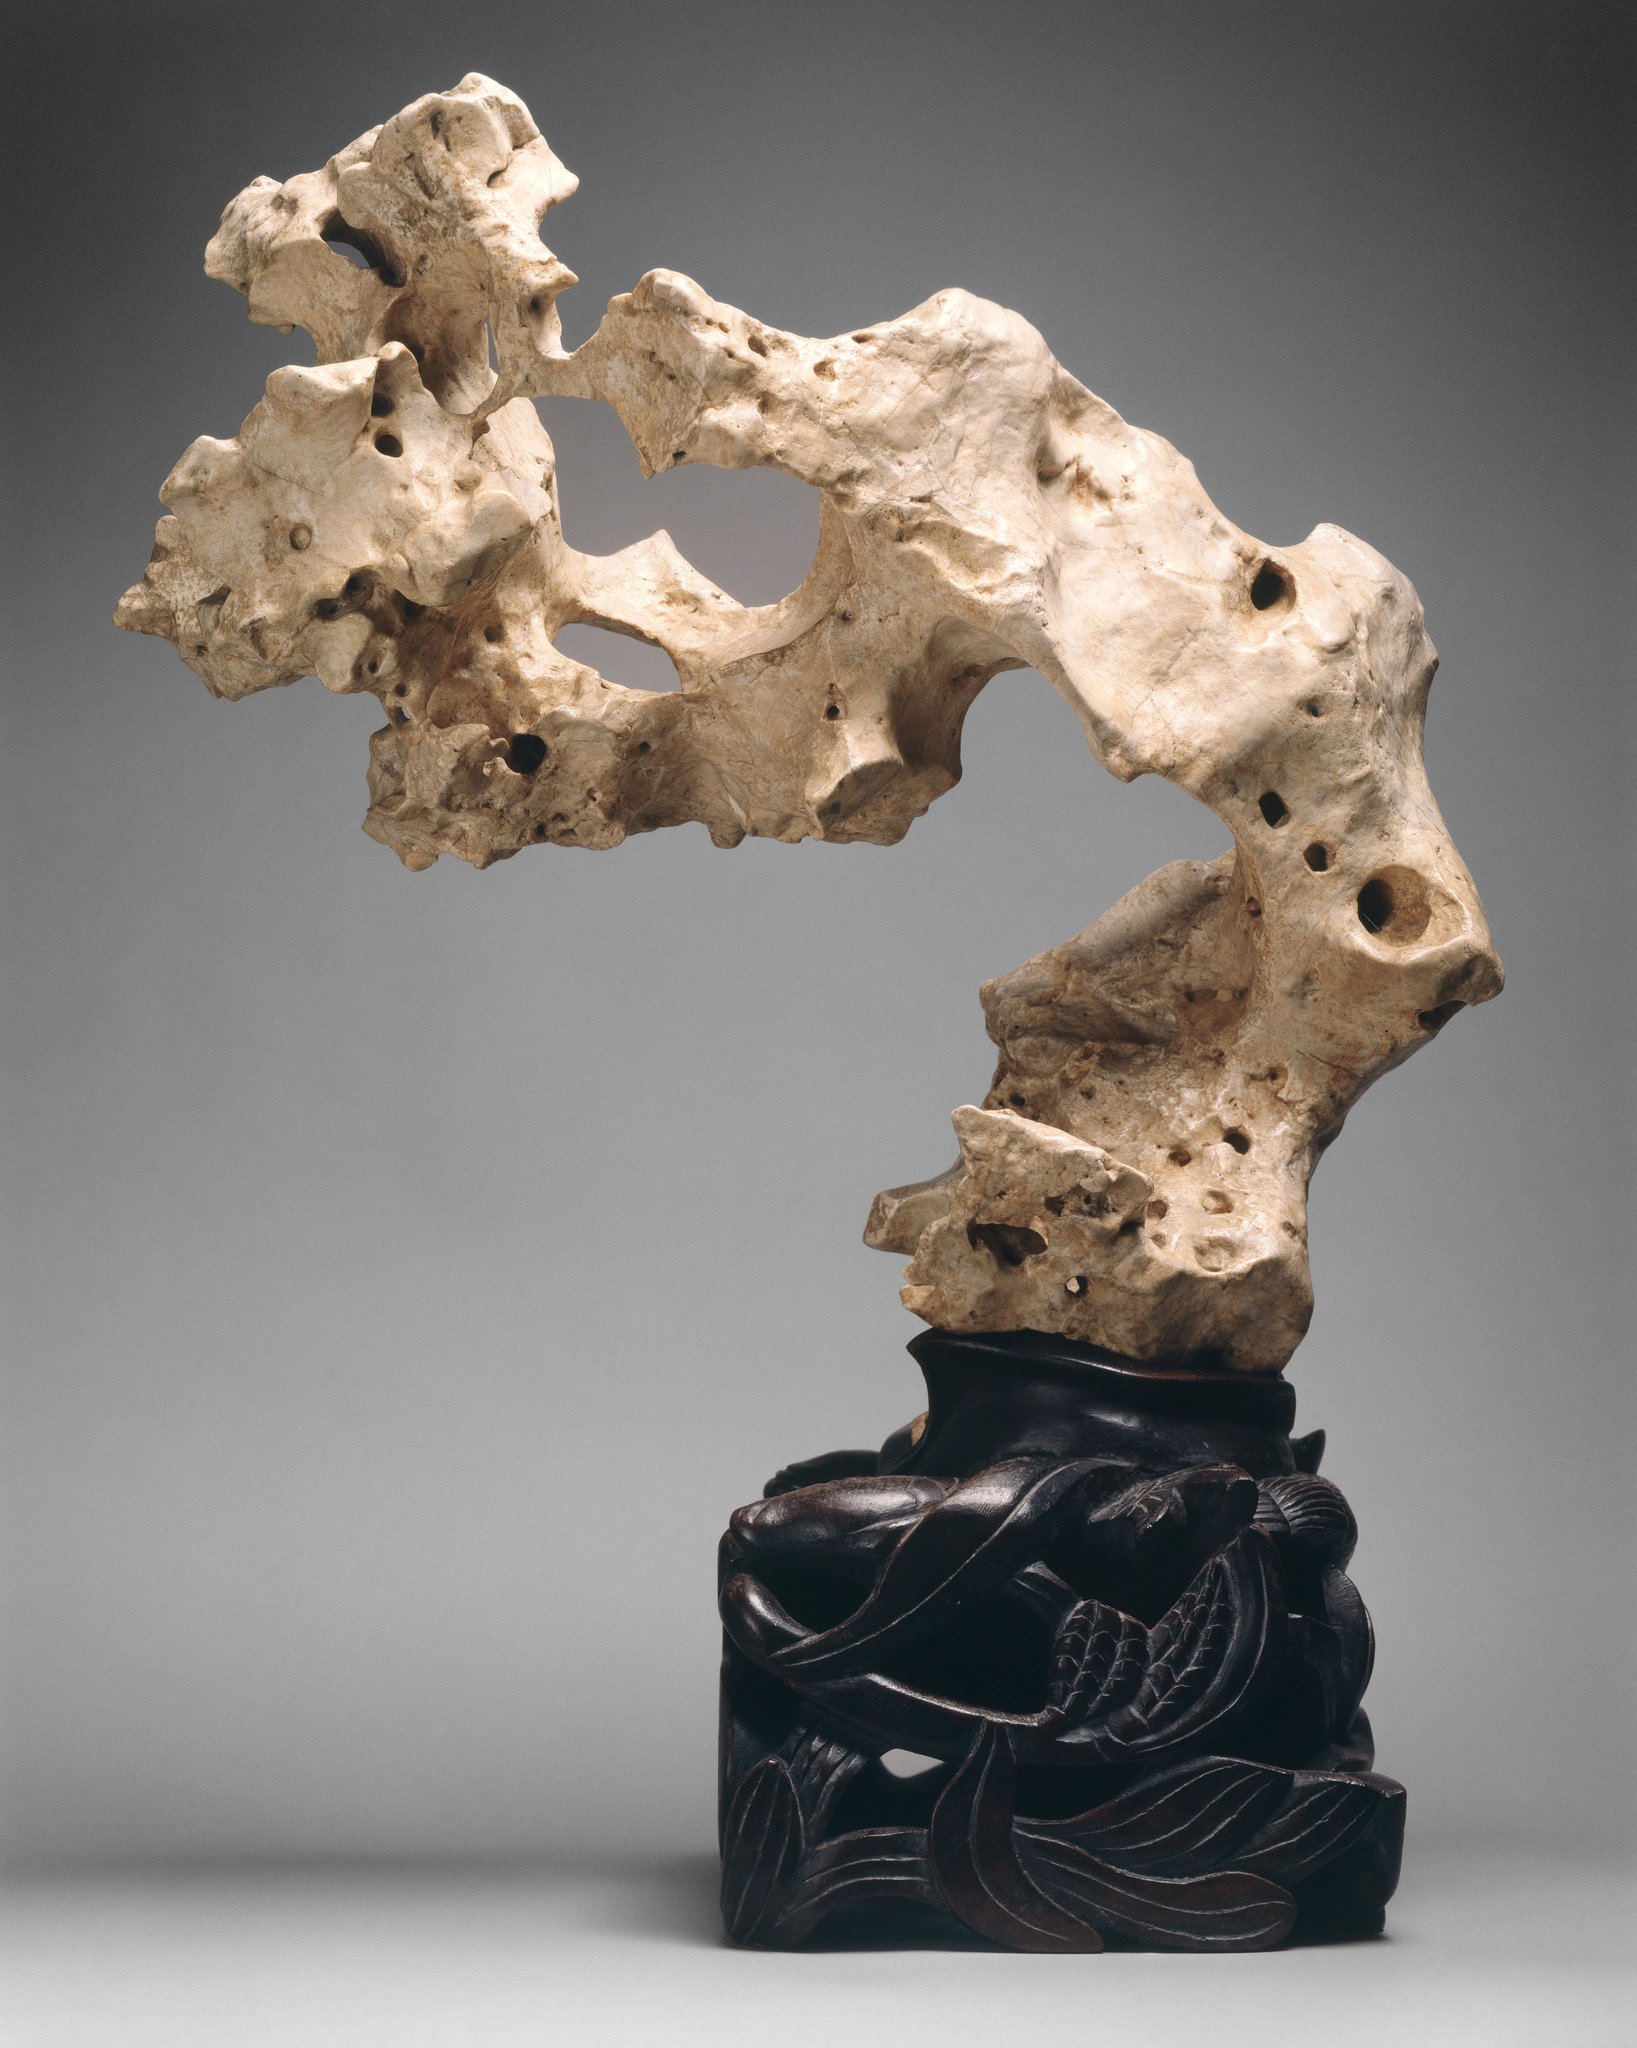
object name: scholar's rock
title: Large rock with pronounced overhang and perforations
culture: chinese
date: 1601-1700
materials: limestone, wood